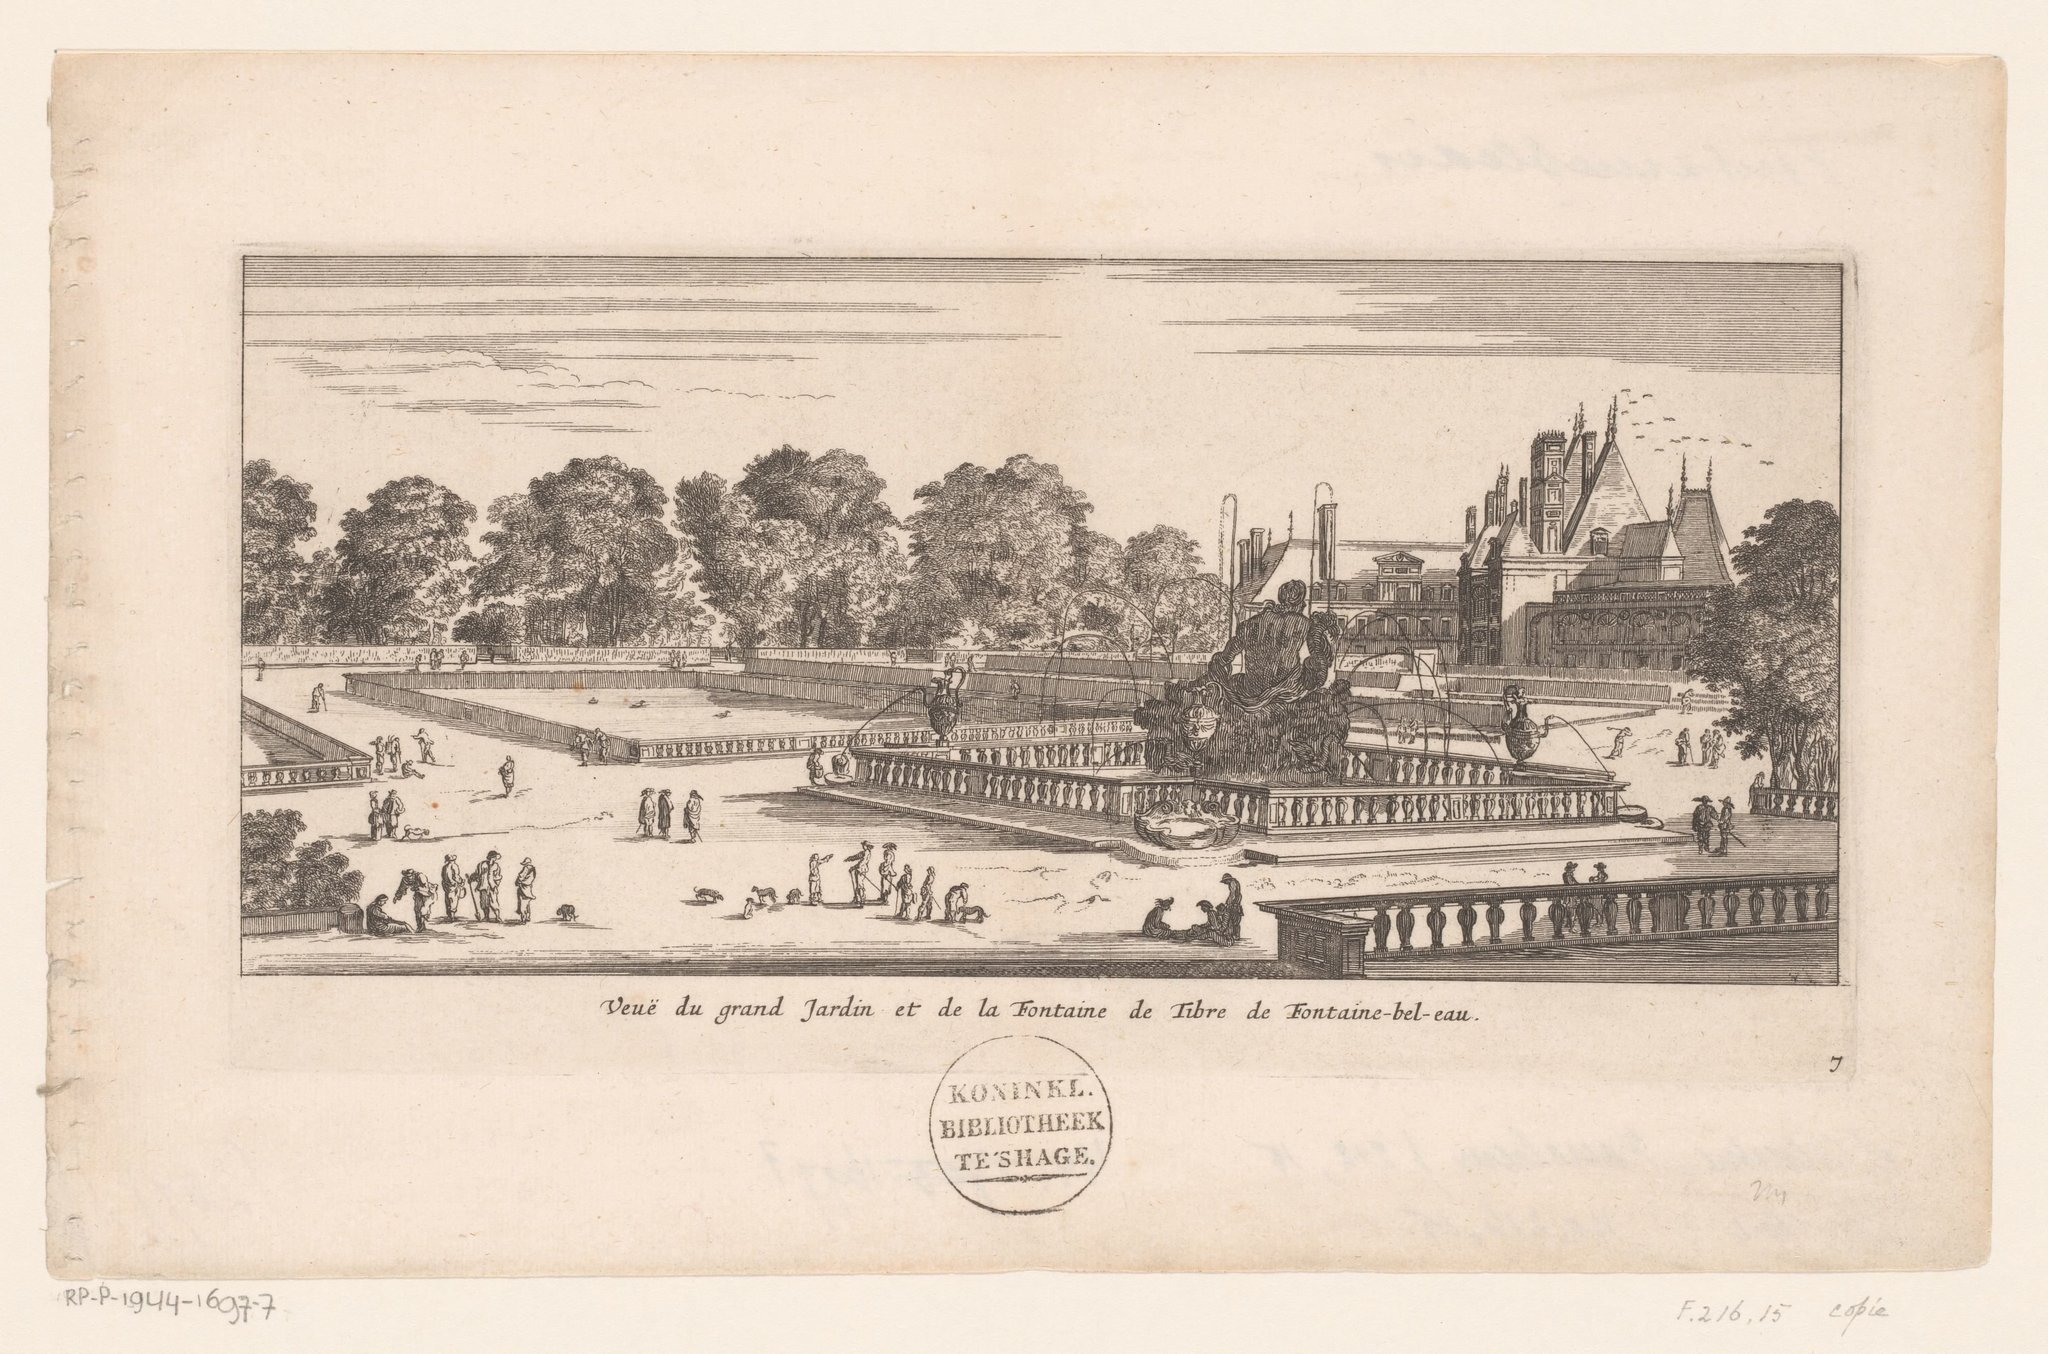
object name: copy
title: Gezichten op kasteel Fontainebleau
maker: Anonymous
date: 1631-1655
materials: paper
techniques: engraving, etching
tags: garden fountain, french or architectonic garden; formal garden, landscape with tower or castle (+ city(-scape) with figures, staffage)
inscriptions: collector's mark: Lugt 2228, collector's mark: ‘Koninkl./ Bibliotheek/ Te'S Hage.’